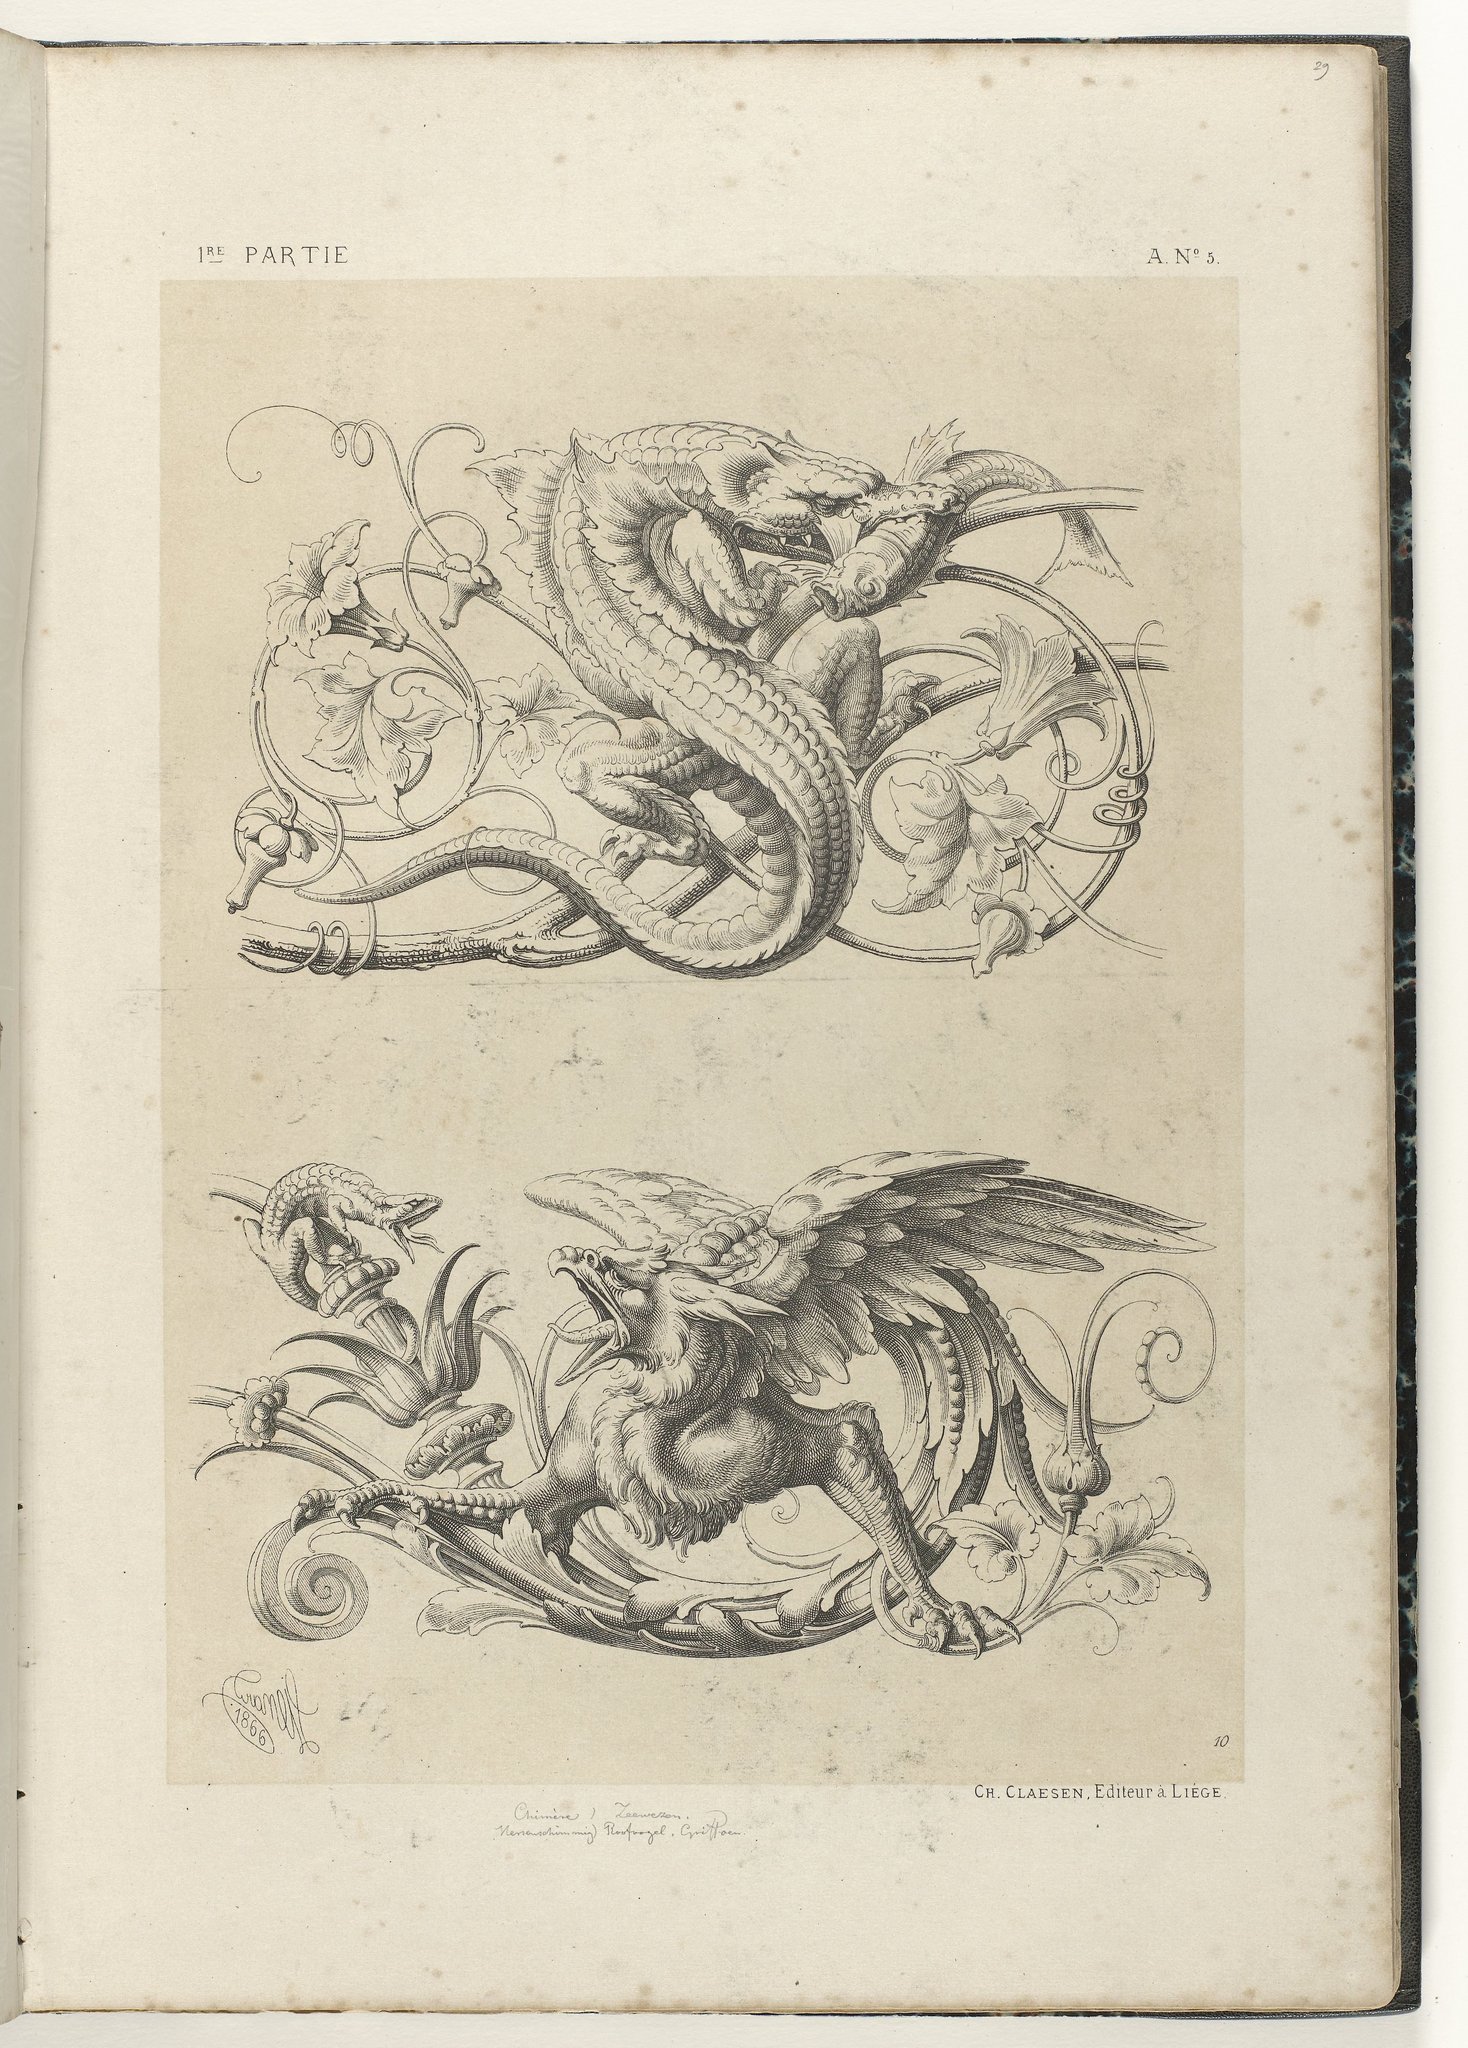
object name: print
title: Draak en griffioen op een bladrank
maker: michel liénard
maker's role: print maker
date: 1866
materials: paper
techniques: tone lithography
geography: liège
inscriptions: annotation: ‘Chimère ) Zeewezen, Hersenschimmig) Roofvogel, Griffioen.’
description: Bovenaan staat een draak met een vis in zijn bek op een bladrank, onderaan spert een griffioen zijn bek open naar een salamander. Linksboven: 1re partie, rechtsboven: A. N° 5., rechtsonder: 10.